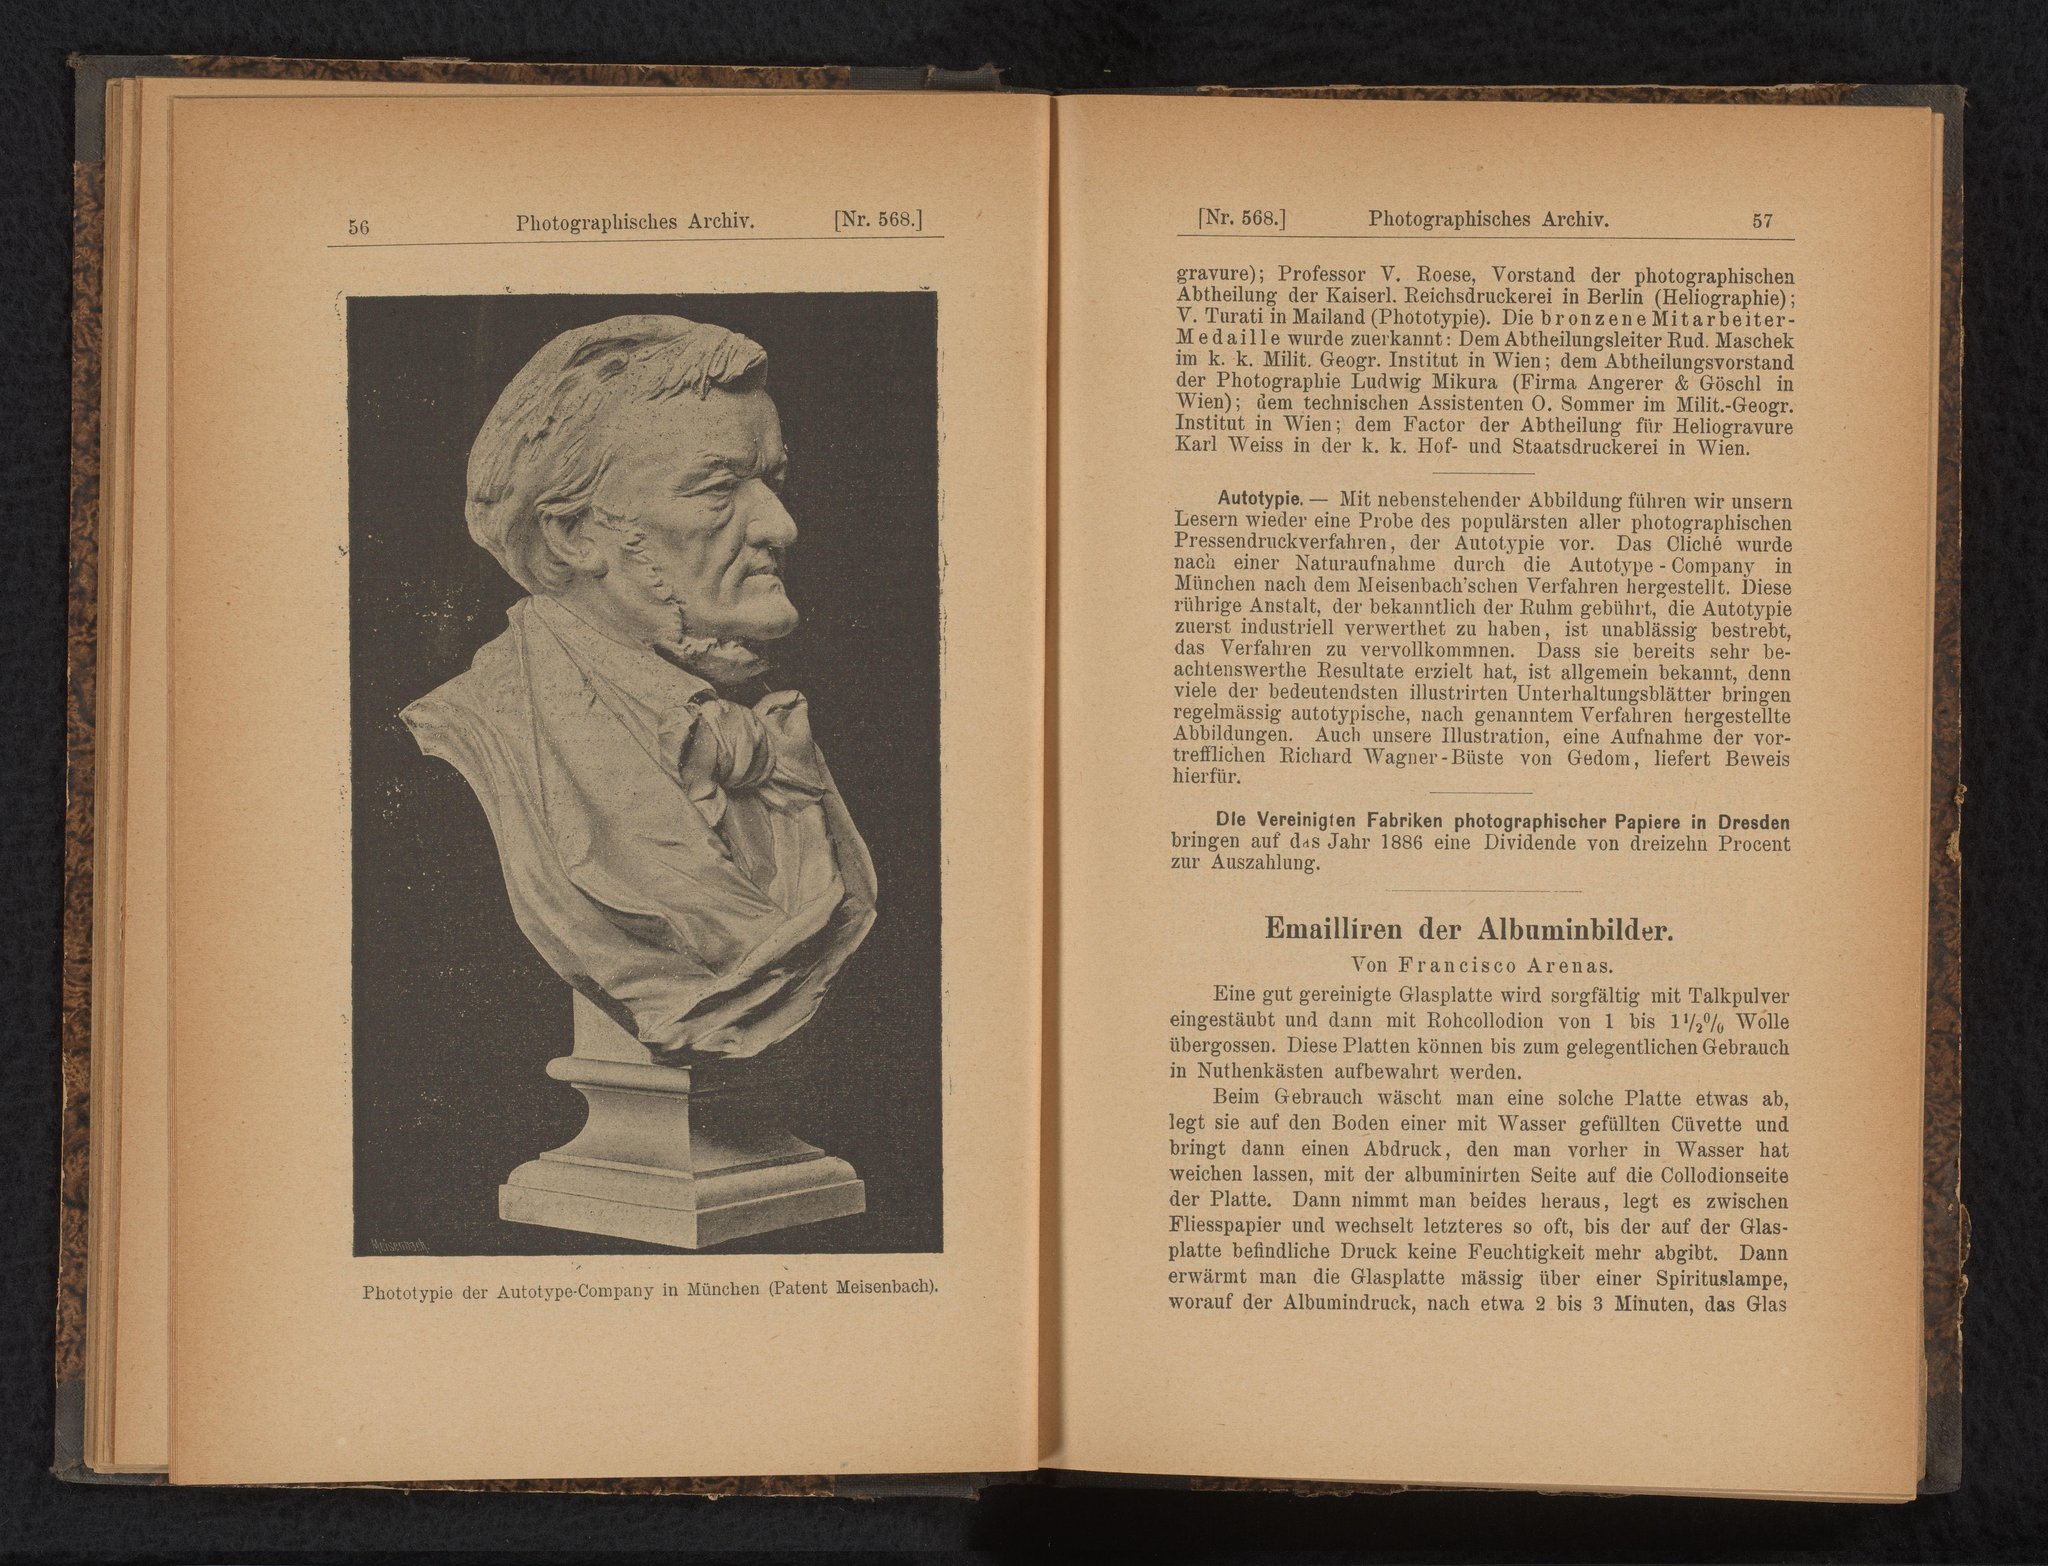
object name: photomechanical print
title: Buste van Richard Wagner door Lorenz Gedon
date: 1882-1887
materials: paper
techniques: autotype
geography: munich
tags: richard wagner, piece of sculpture, reproduction of a piece of sculpture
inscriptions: inscription: ‘Phototypie der Autotype-Company in München (Patent Meisenbach).’, signature: ‘Meisenbach’